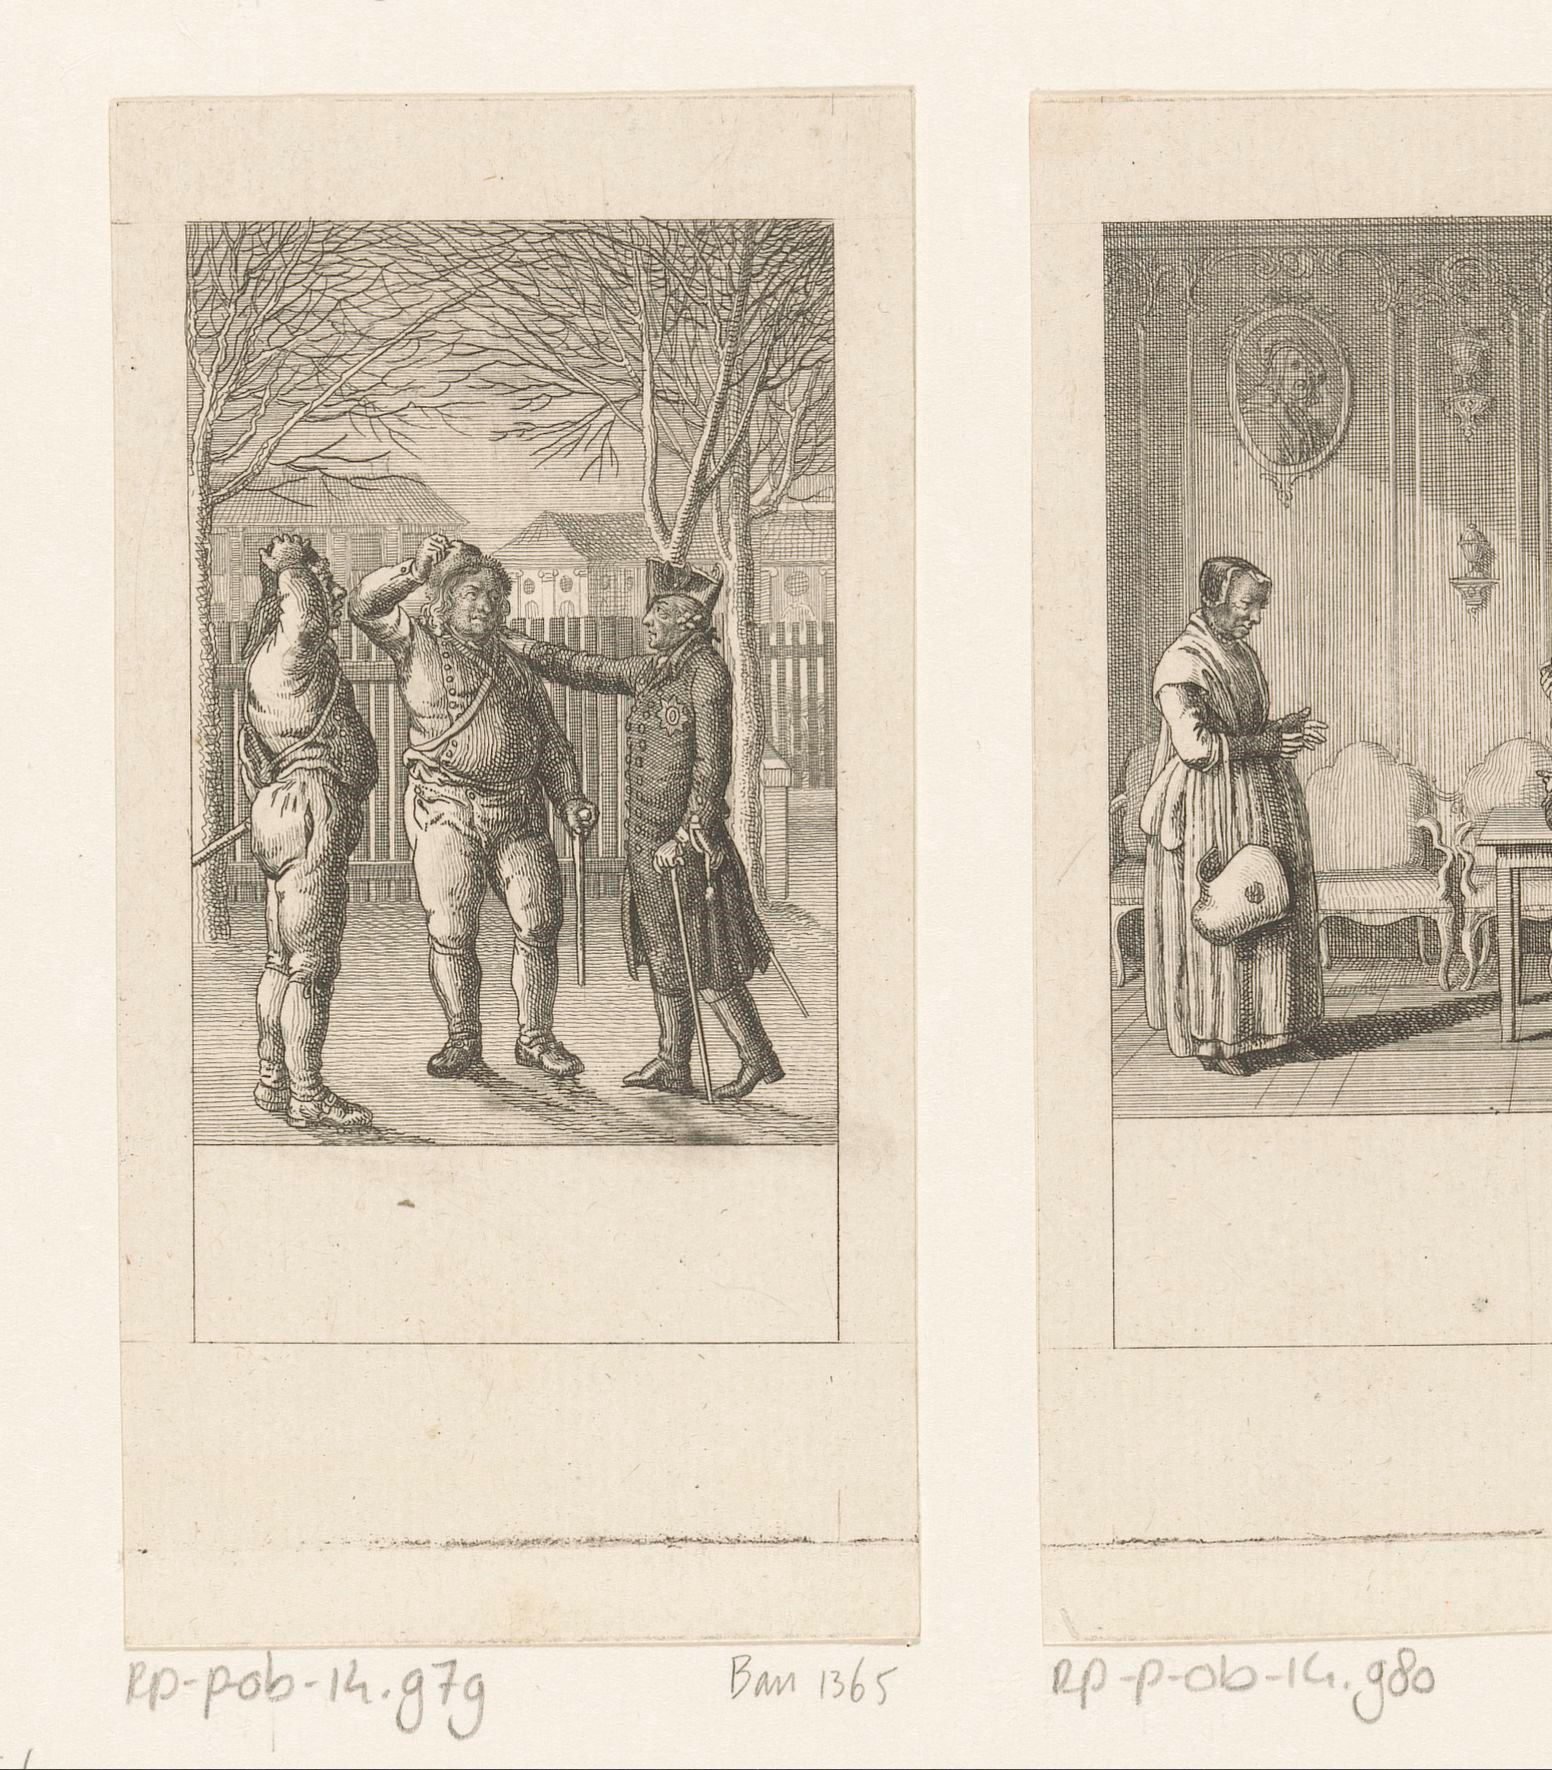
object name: print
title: Frederik II toont zichzelf aan de zakkendragers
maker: daniel nikolaus chodowiecki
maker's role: draughtsman, print maker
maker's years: 1726-1801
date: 1788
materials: paper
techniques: etching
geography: berlin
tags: frederick ii (king of prussia), ruler, sovereign, disguise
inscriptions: collector's mark: Lugt 2228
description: Latere staat gebruikt voor: Gothaischer Hof Kalender zum Nutzen und Vergnügen eingerichtet auf das Jahr 1789. Gotha: C. W. Ettinger, [1788].